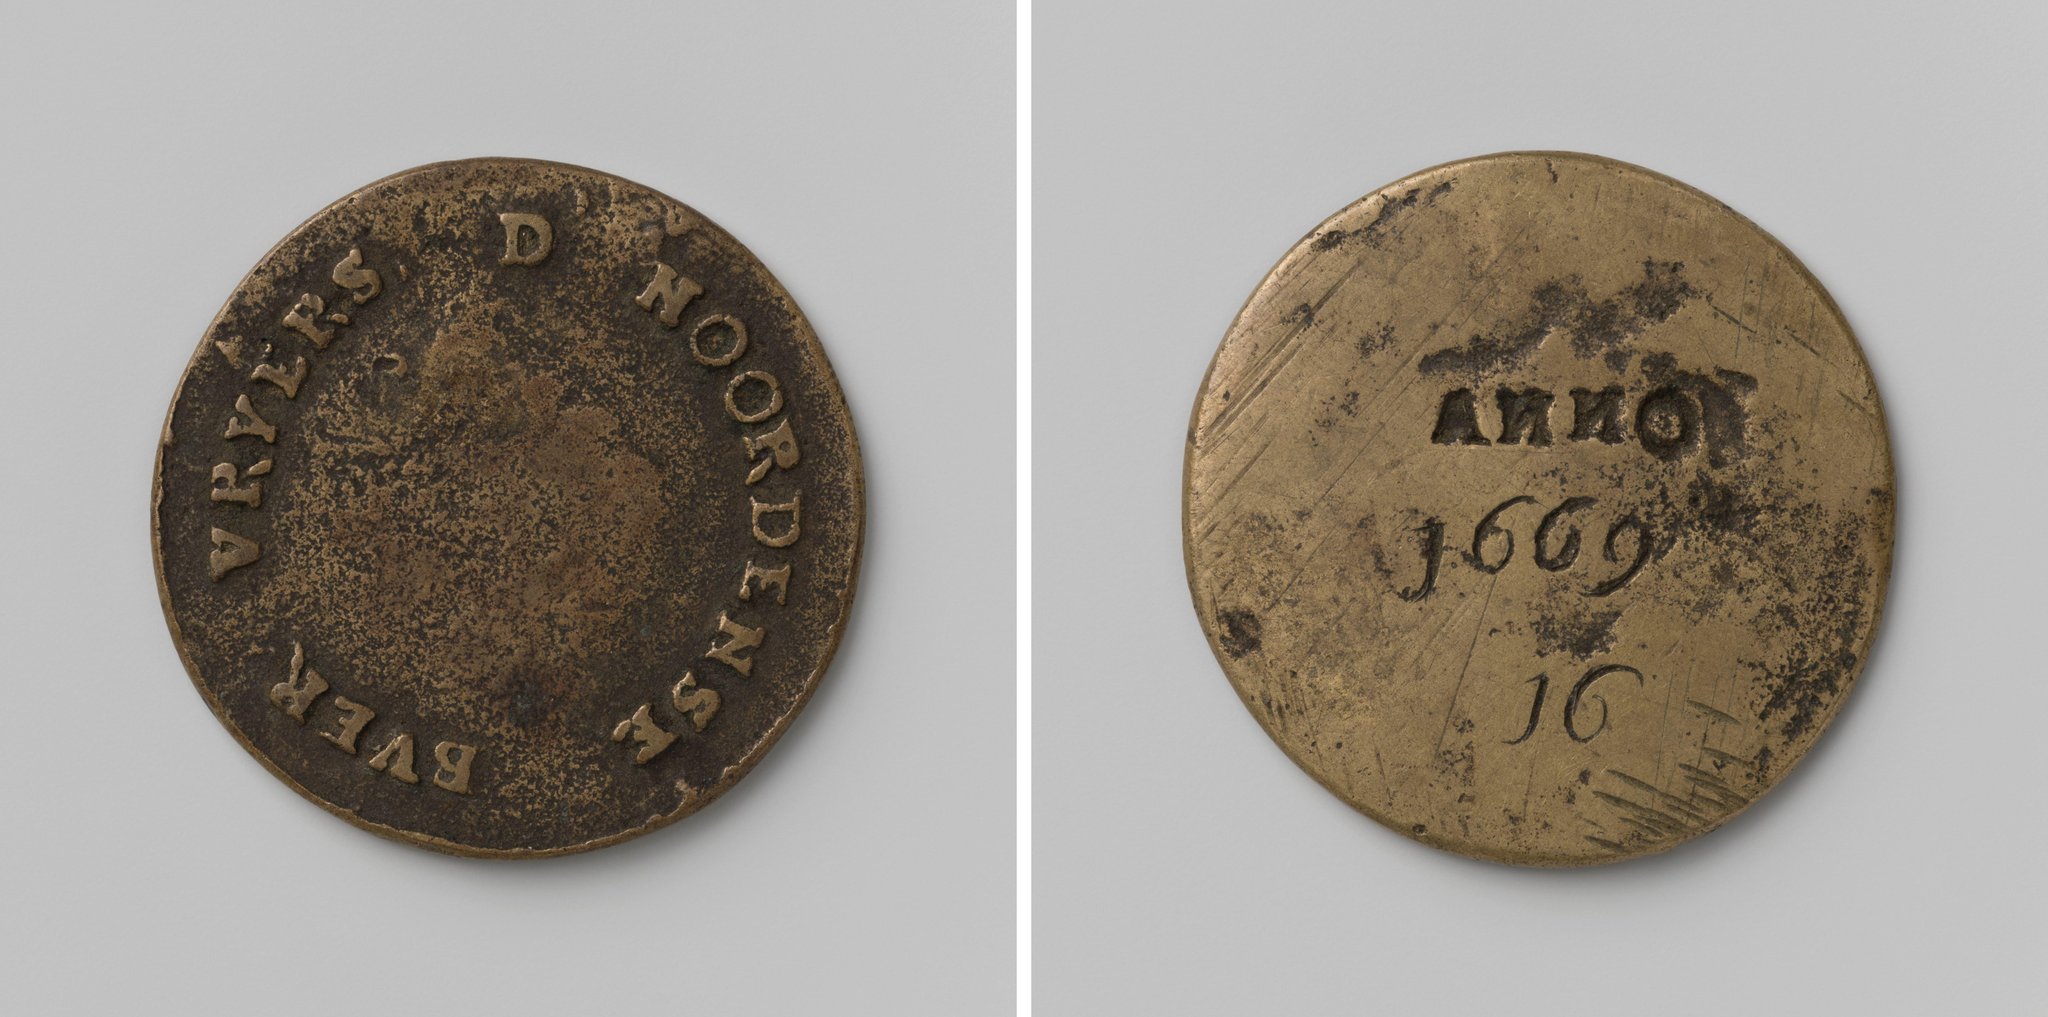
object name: buurtpenning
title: Buurt Noordeinde te 's-Gravenhage, buurtpenning van de buurtvrijers met no. 16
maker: Anonymous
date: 1669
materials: brass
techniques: casting, engraving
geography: the hague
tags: noordeinde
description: Messing penning. Voorzijde: leeg veld binnen omschrift. Keerzijde: jaartal boven cijfer 16